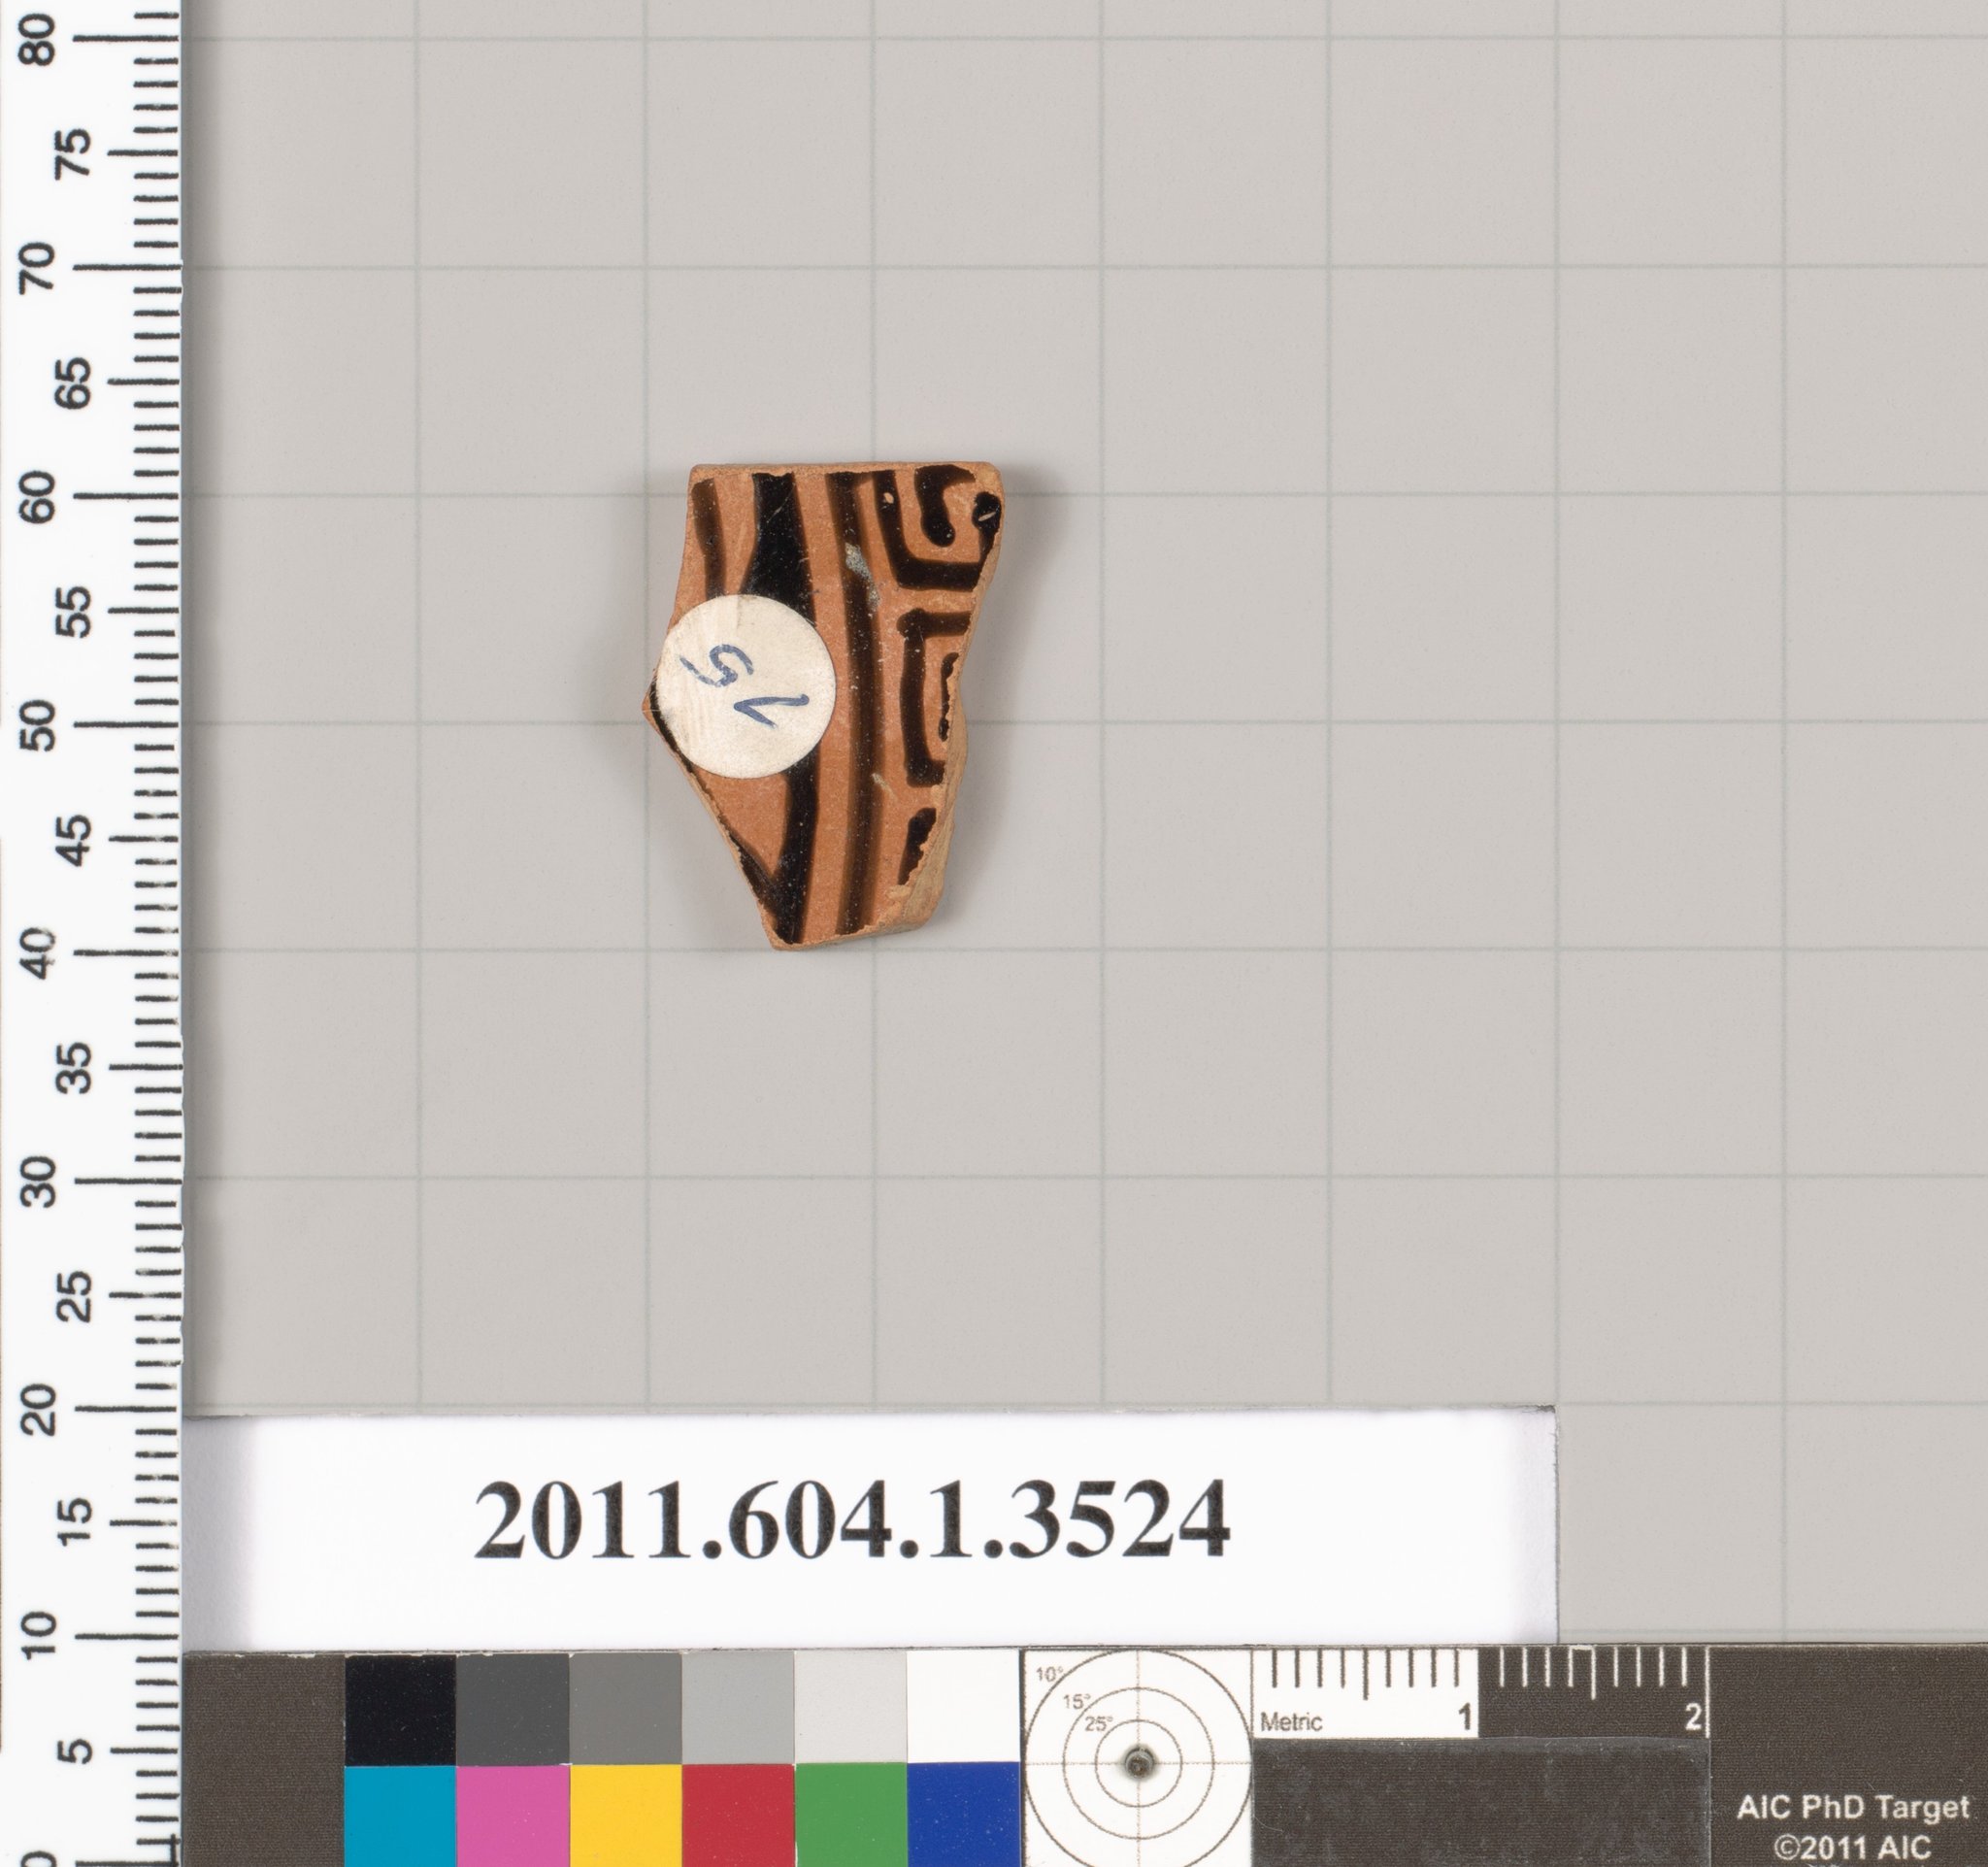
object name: kylix fragment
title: Terracotta fragment of a kylix (drinking cup)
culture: greek, attic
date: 475-451 BCE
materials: terracotta